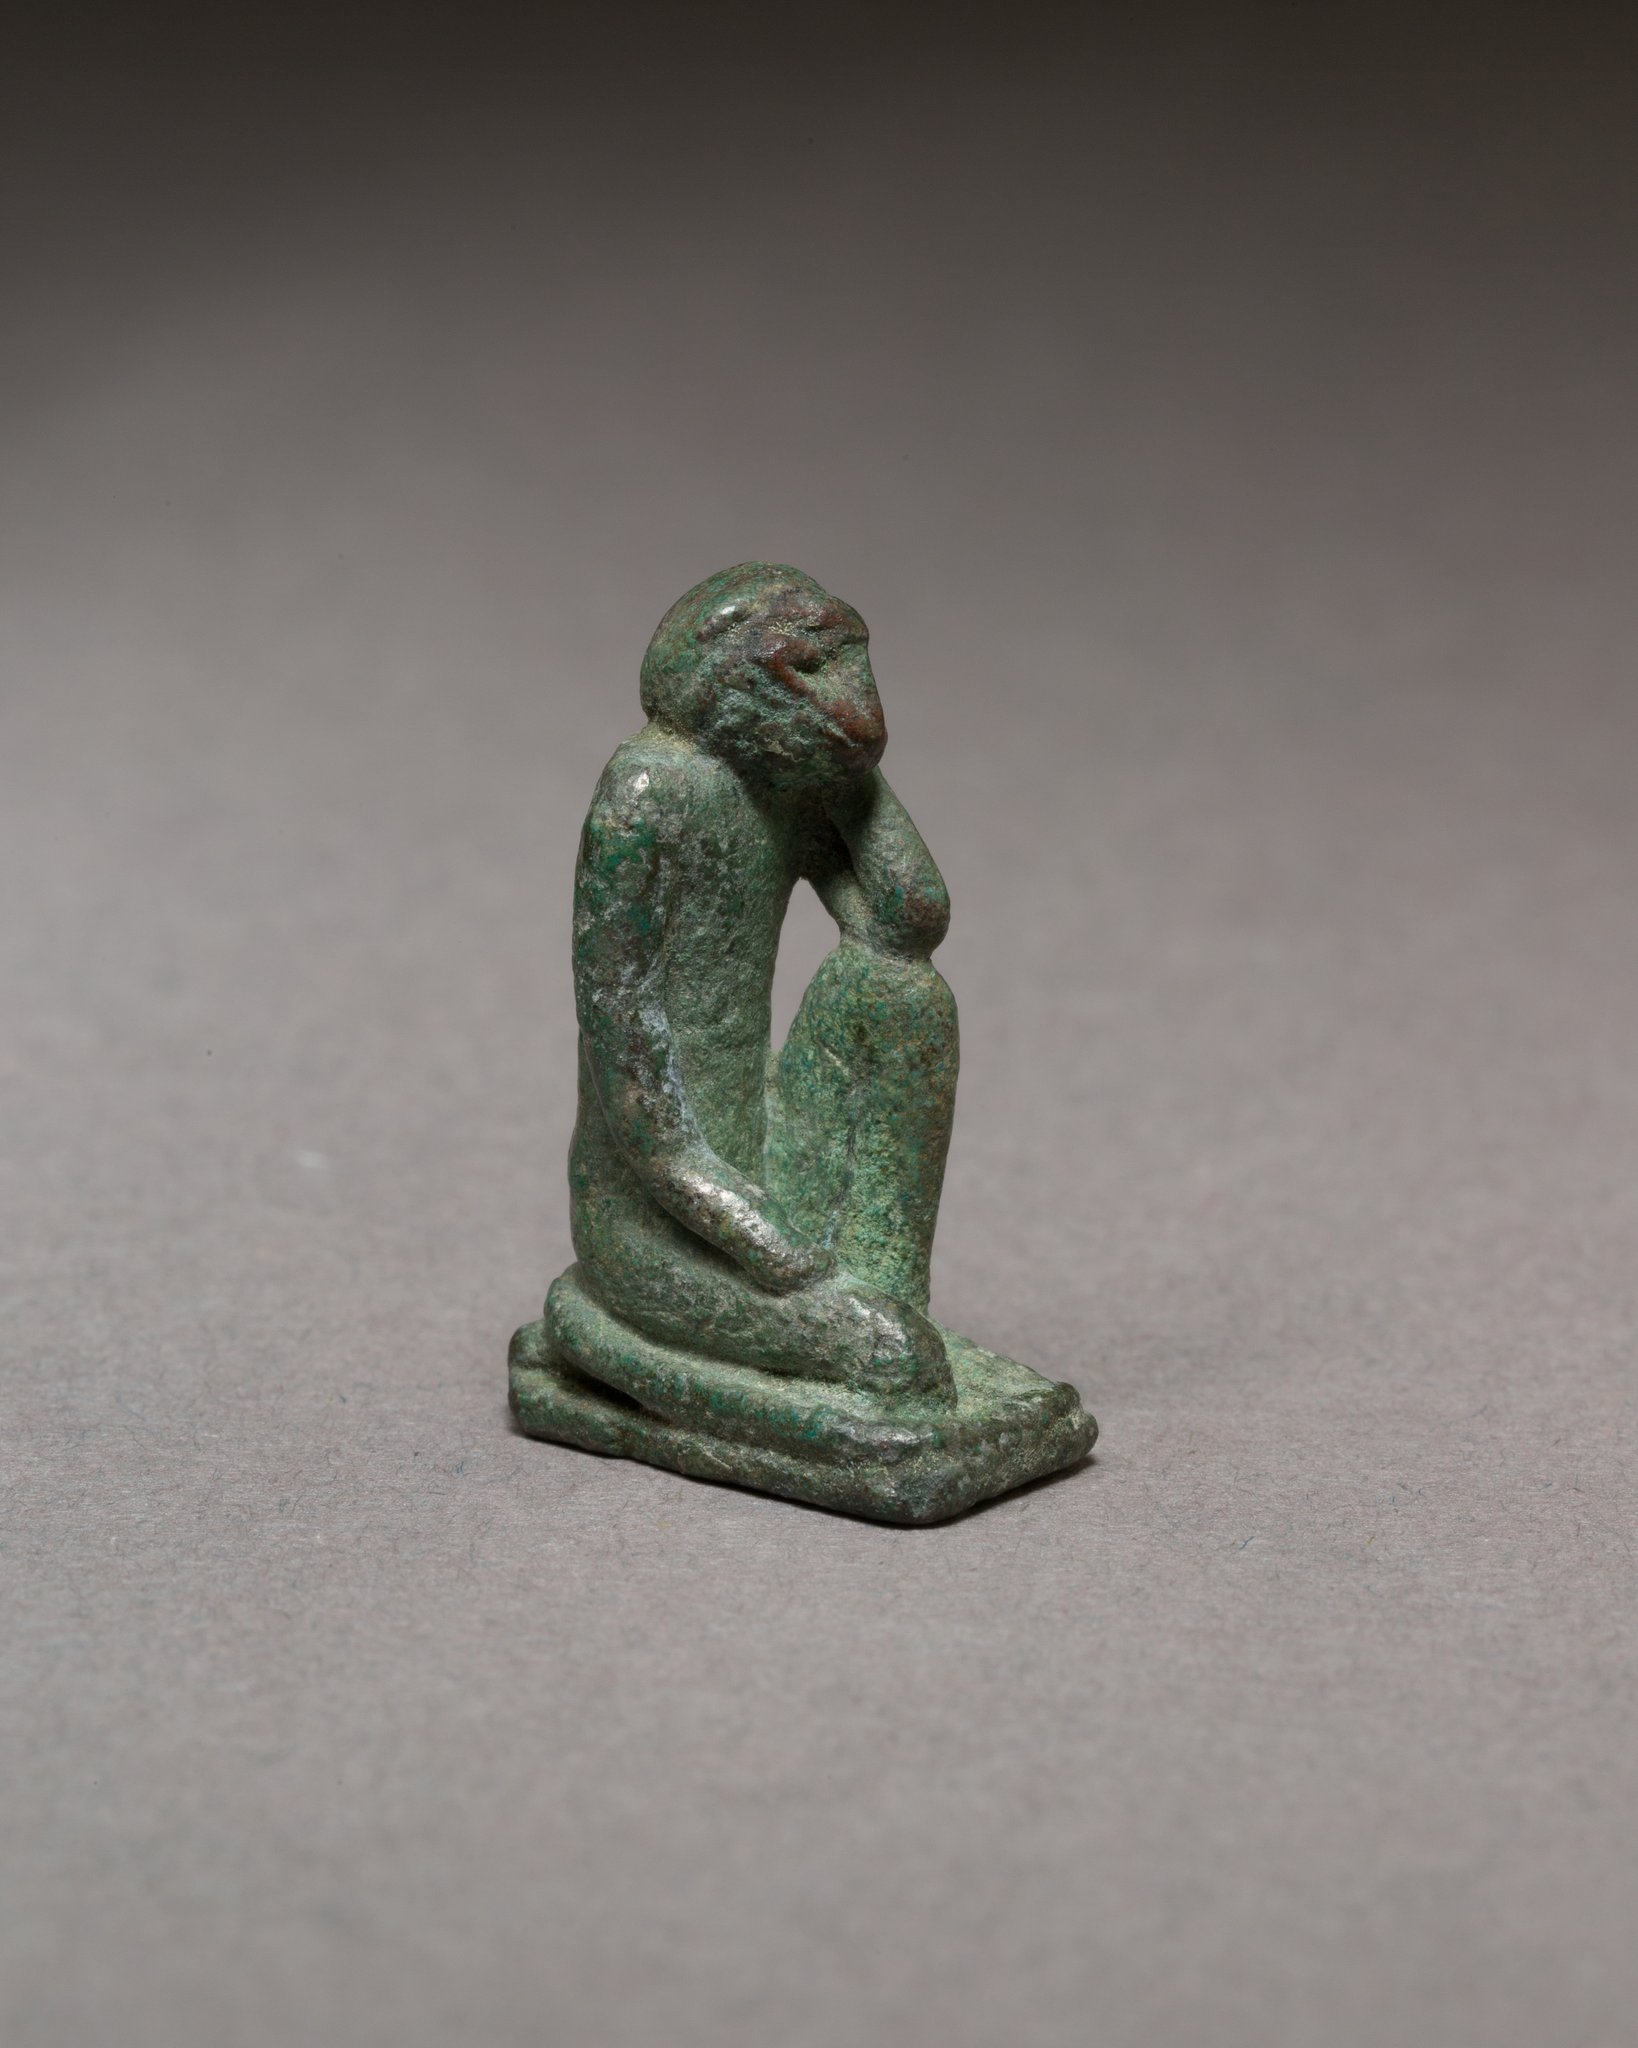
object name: figurine, monkey kneeling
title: Monkey kneeling and resting its head in a hand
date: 500-100 BCE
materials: bronze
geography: egypt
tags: monkeys